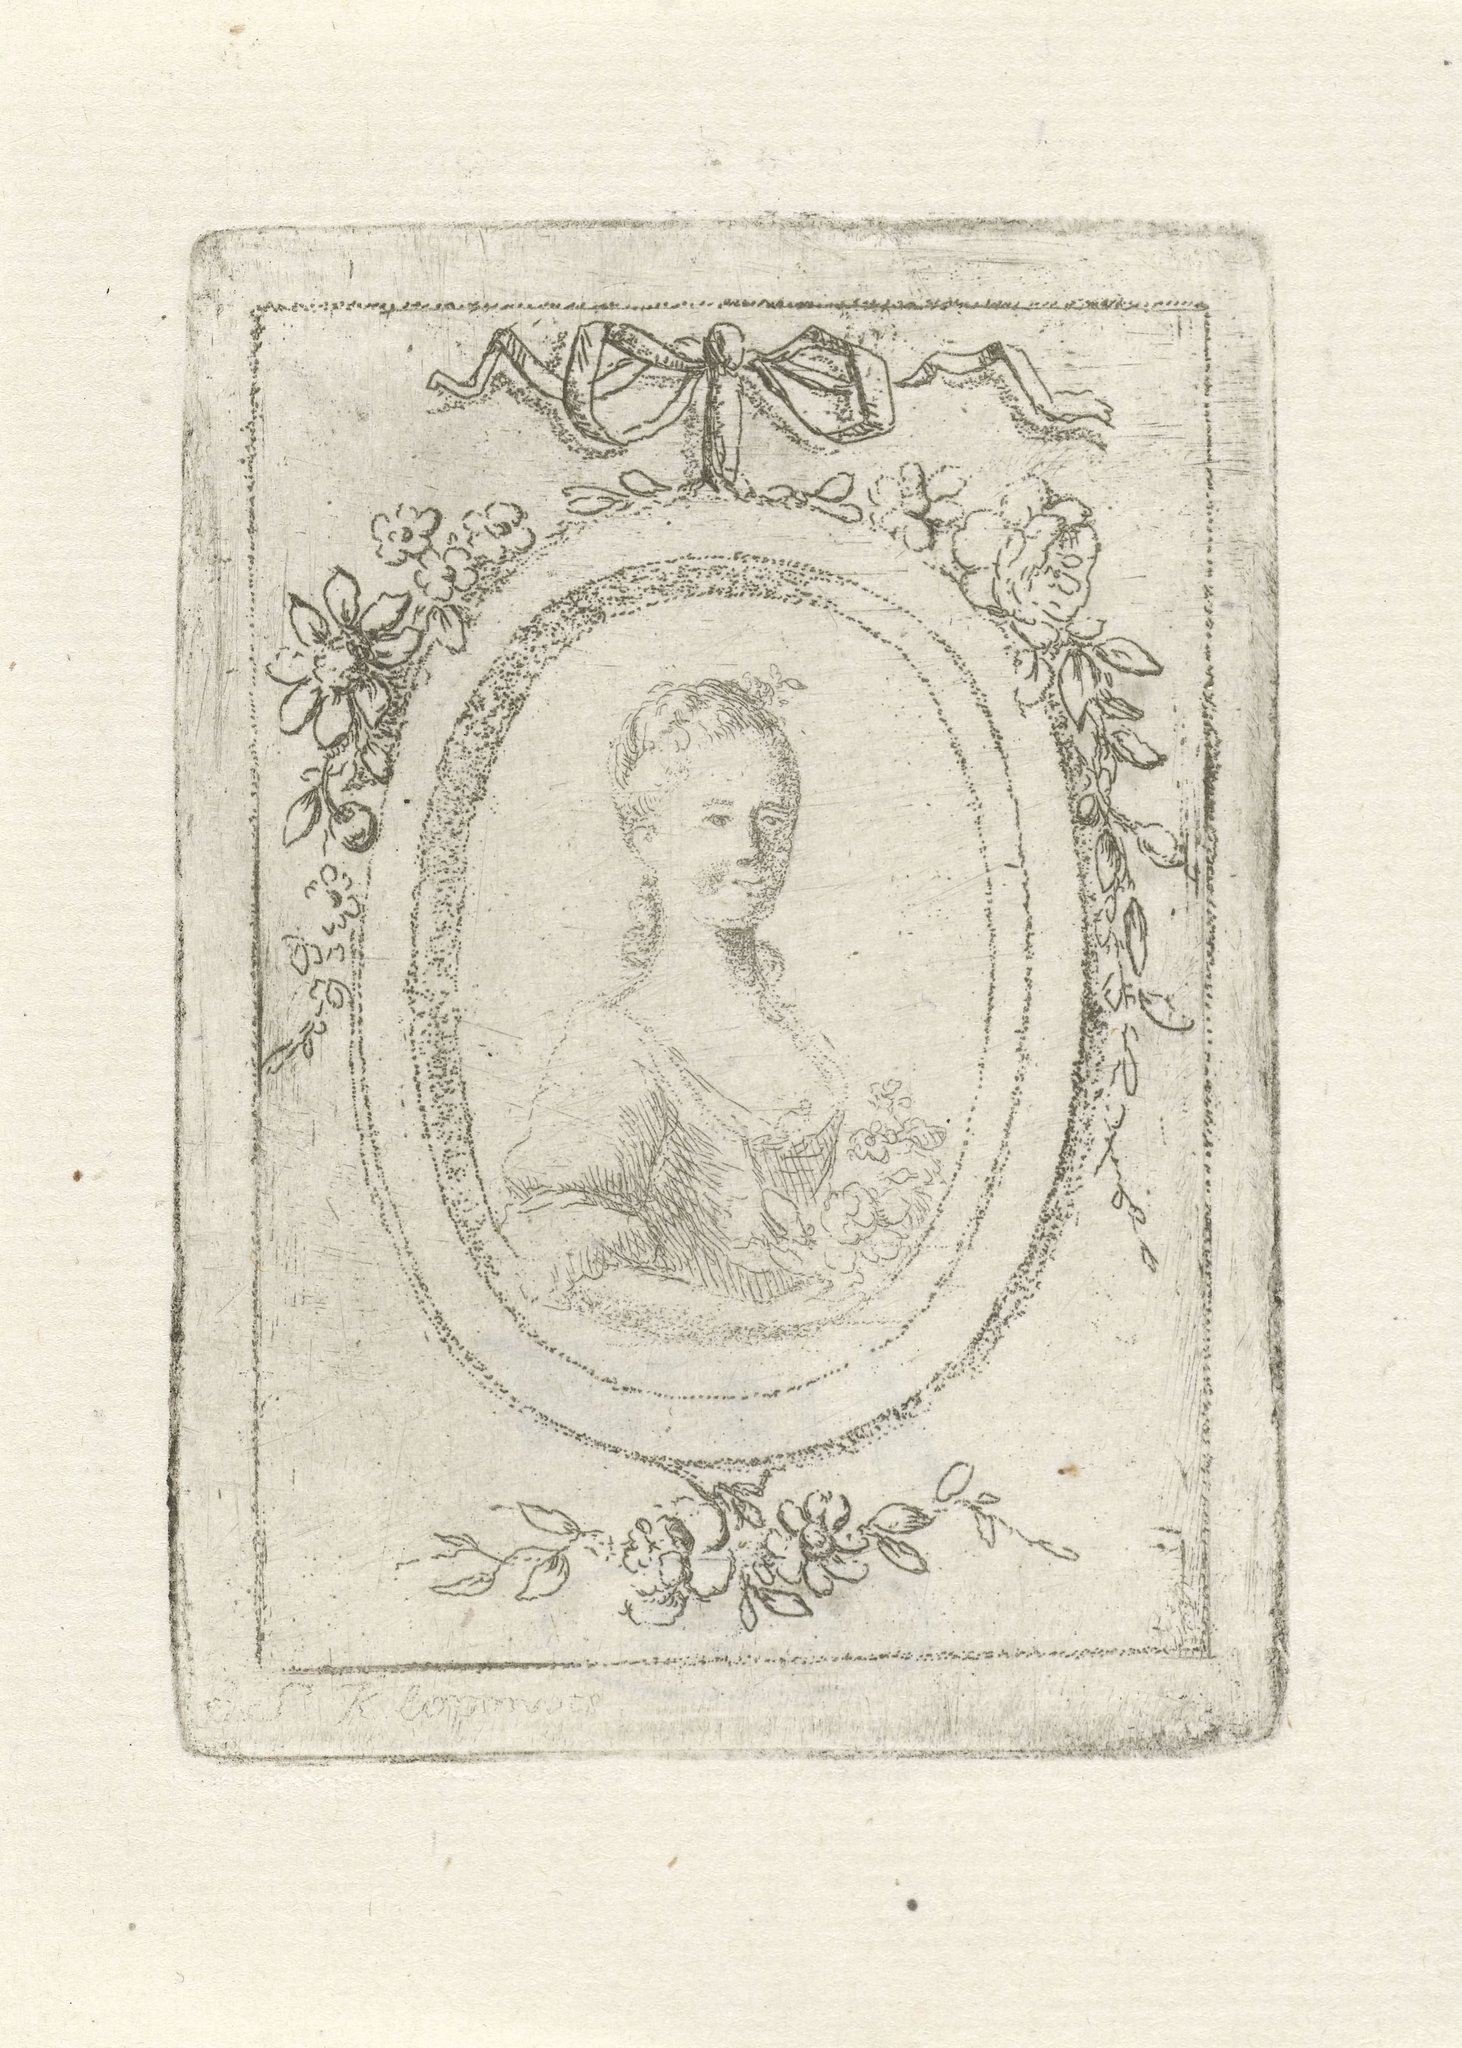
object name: print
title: Portret van een onbekende jonge vrouw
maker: simon klapmuts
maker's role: print maker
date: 1744-1780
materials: paper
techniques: etching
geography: moordrecht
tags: flowers, adolescent, young woman, maiden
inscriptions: collector's mark: Lugt 2228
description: Portret van een onbekende jonge vrouw met bloemen in de hand, gevat in een medaillon versierd met een guirlande.